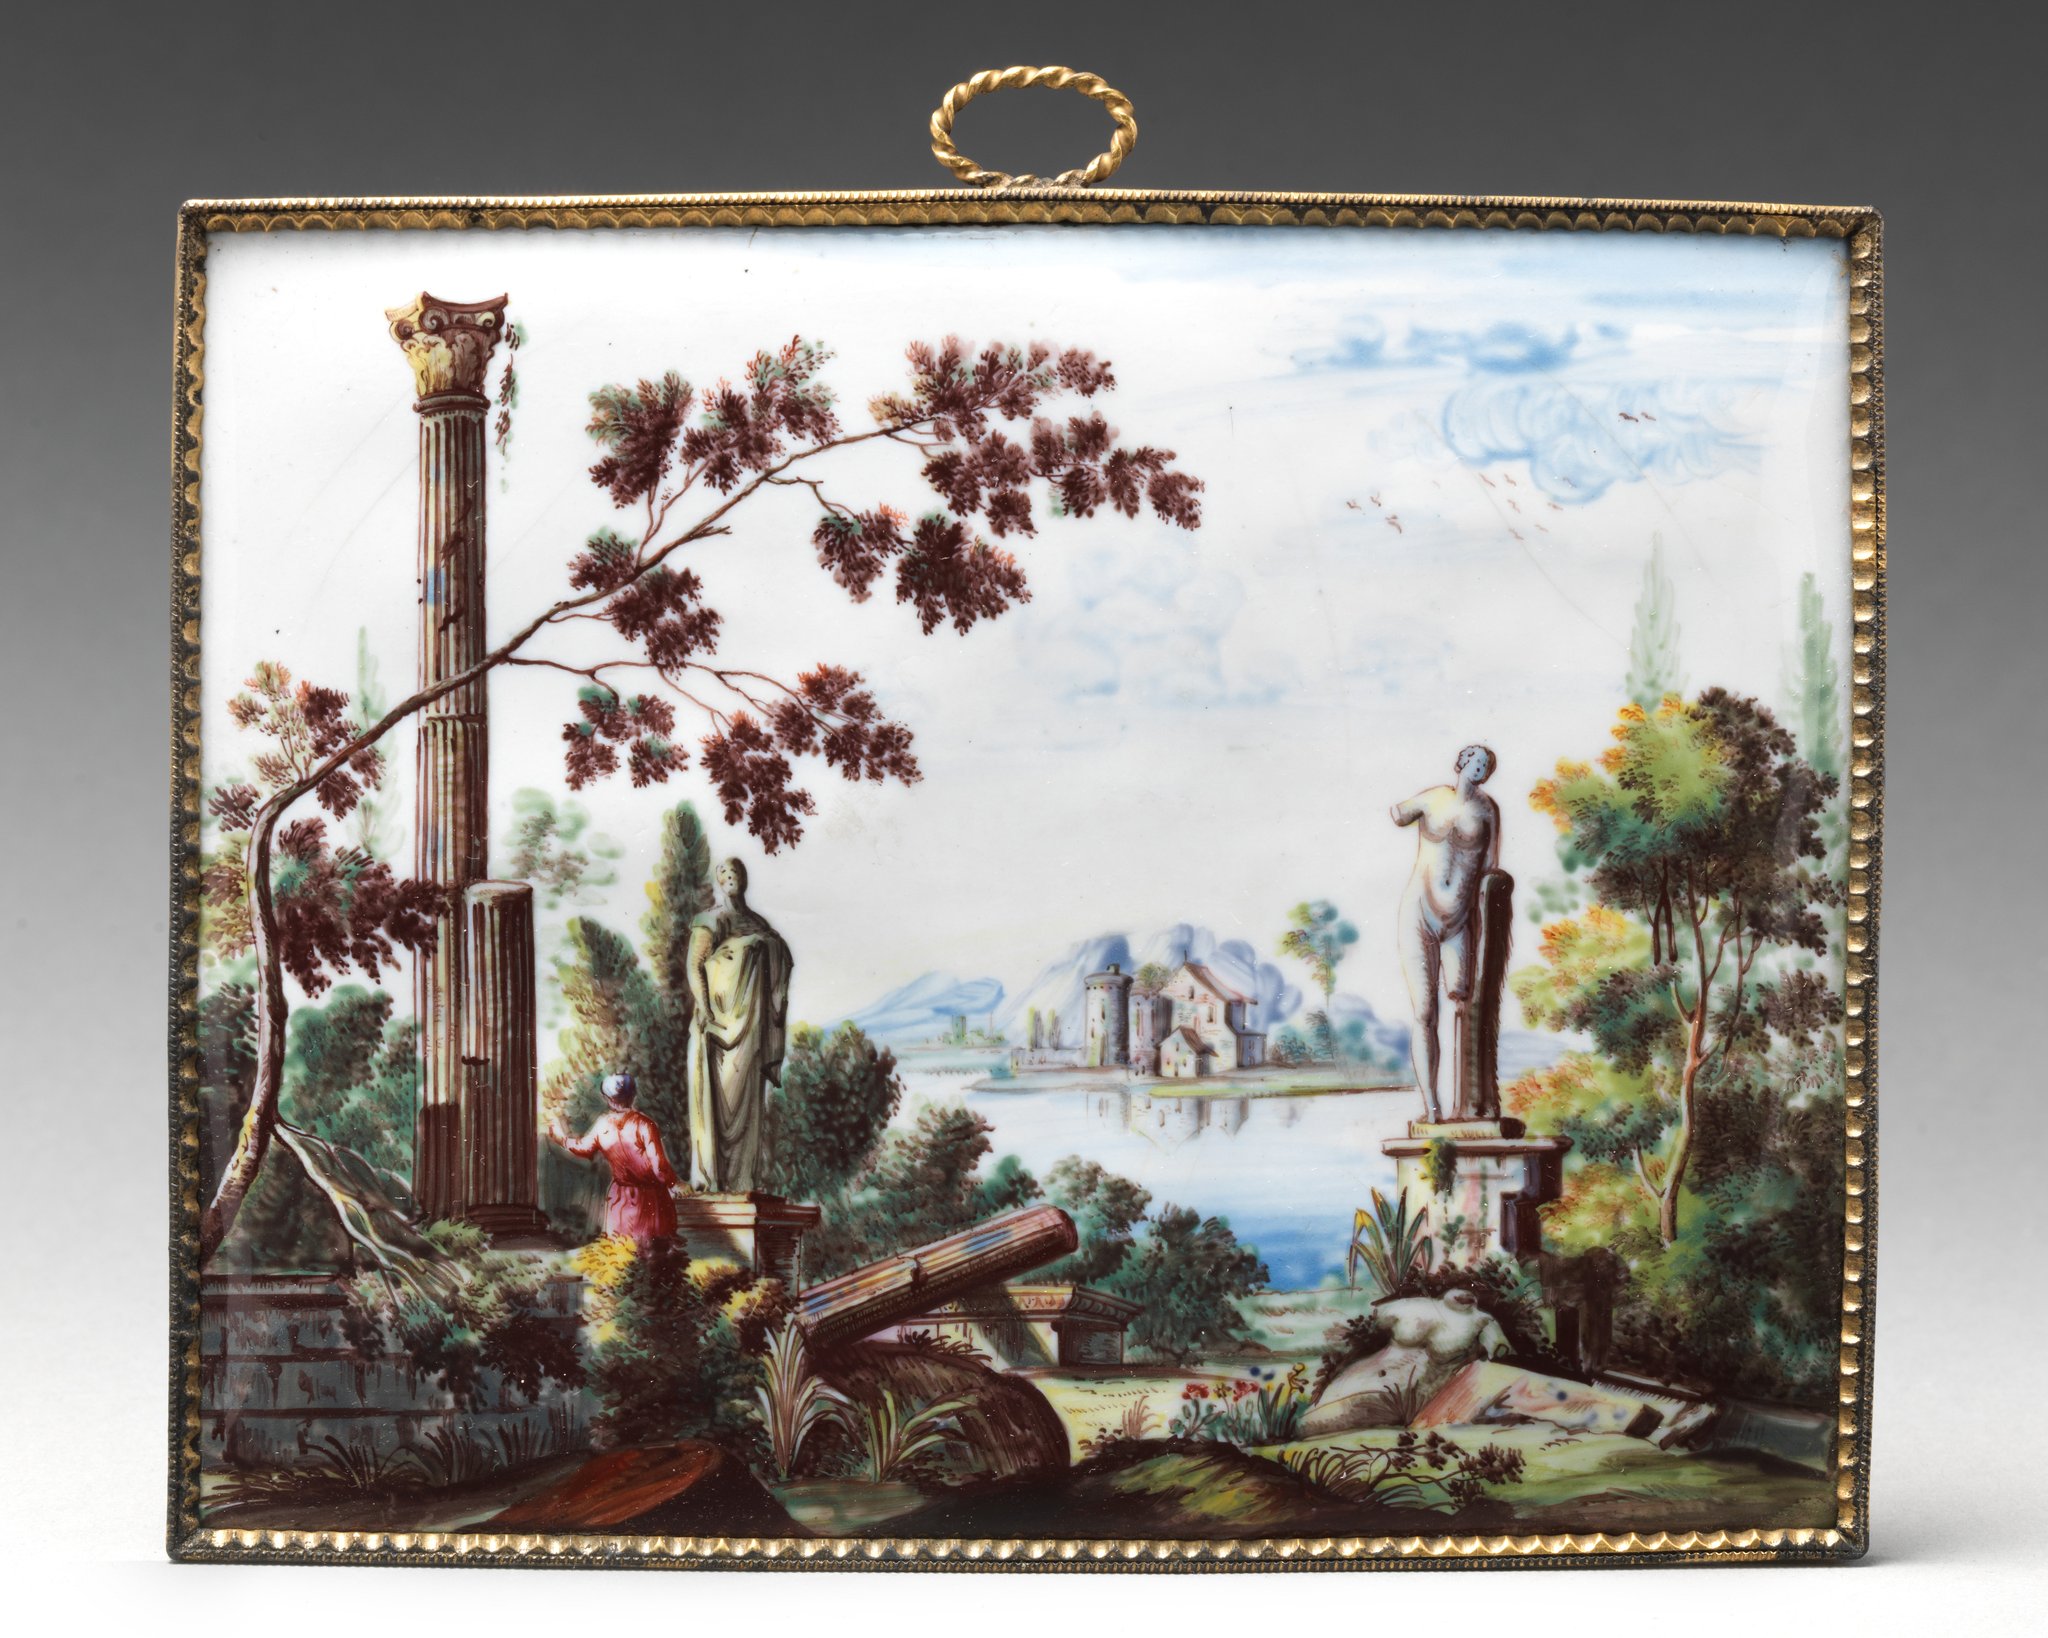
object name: plaque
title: Plaque with classical landscape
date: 1755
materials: copper, enamel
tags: ruins,landscapes